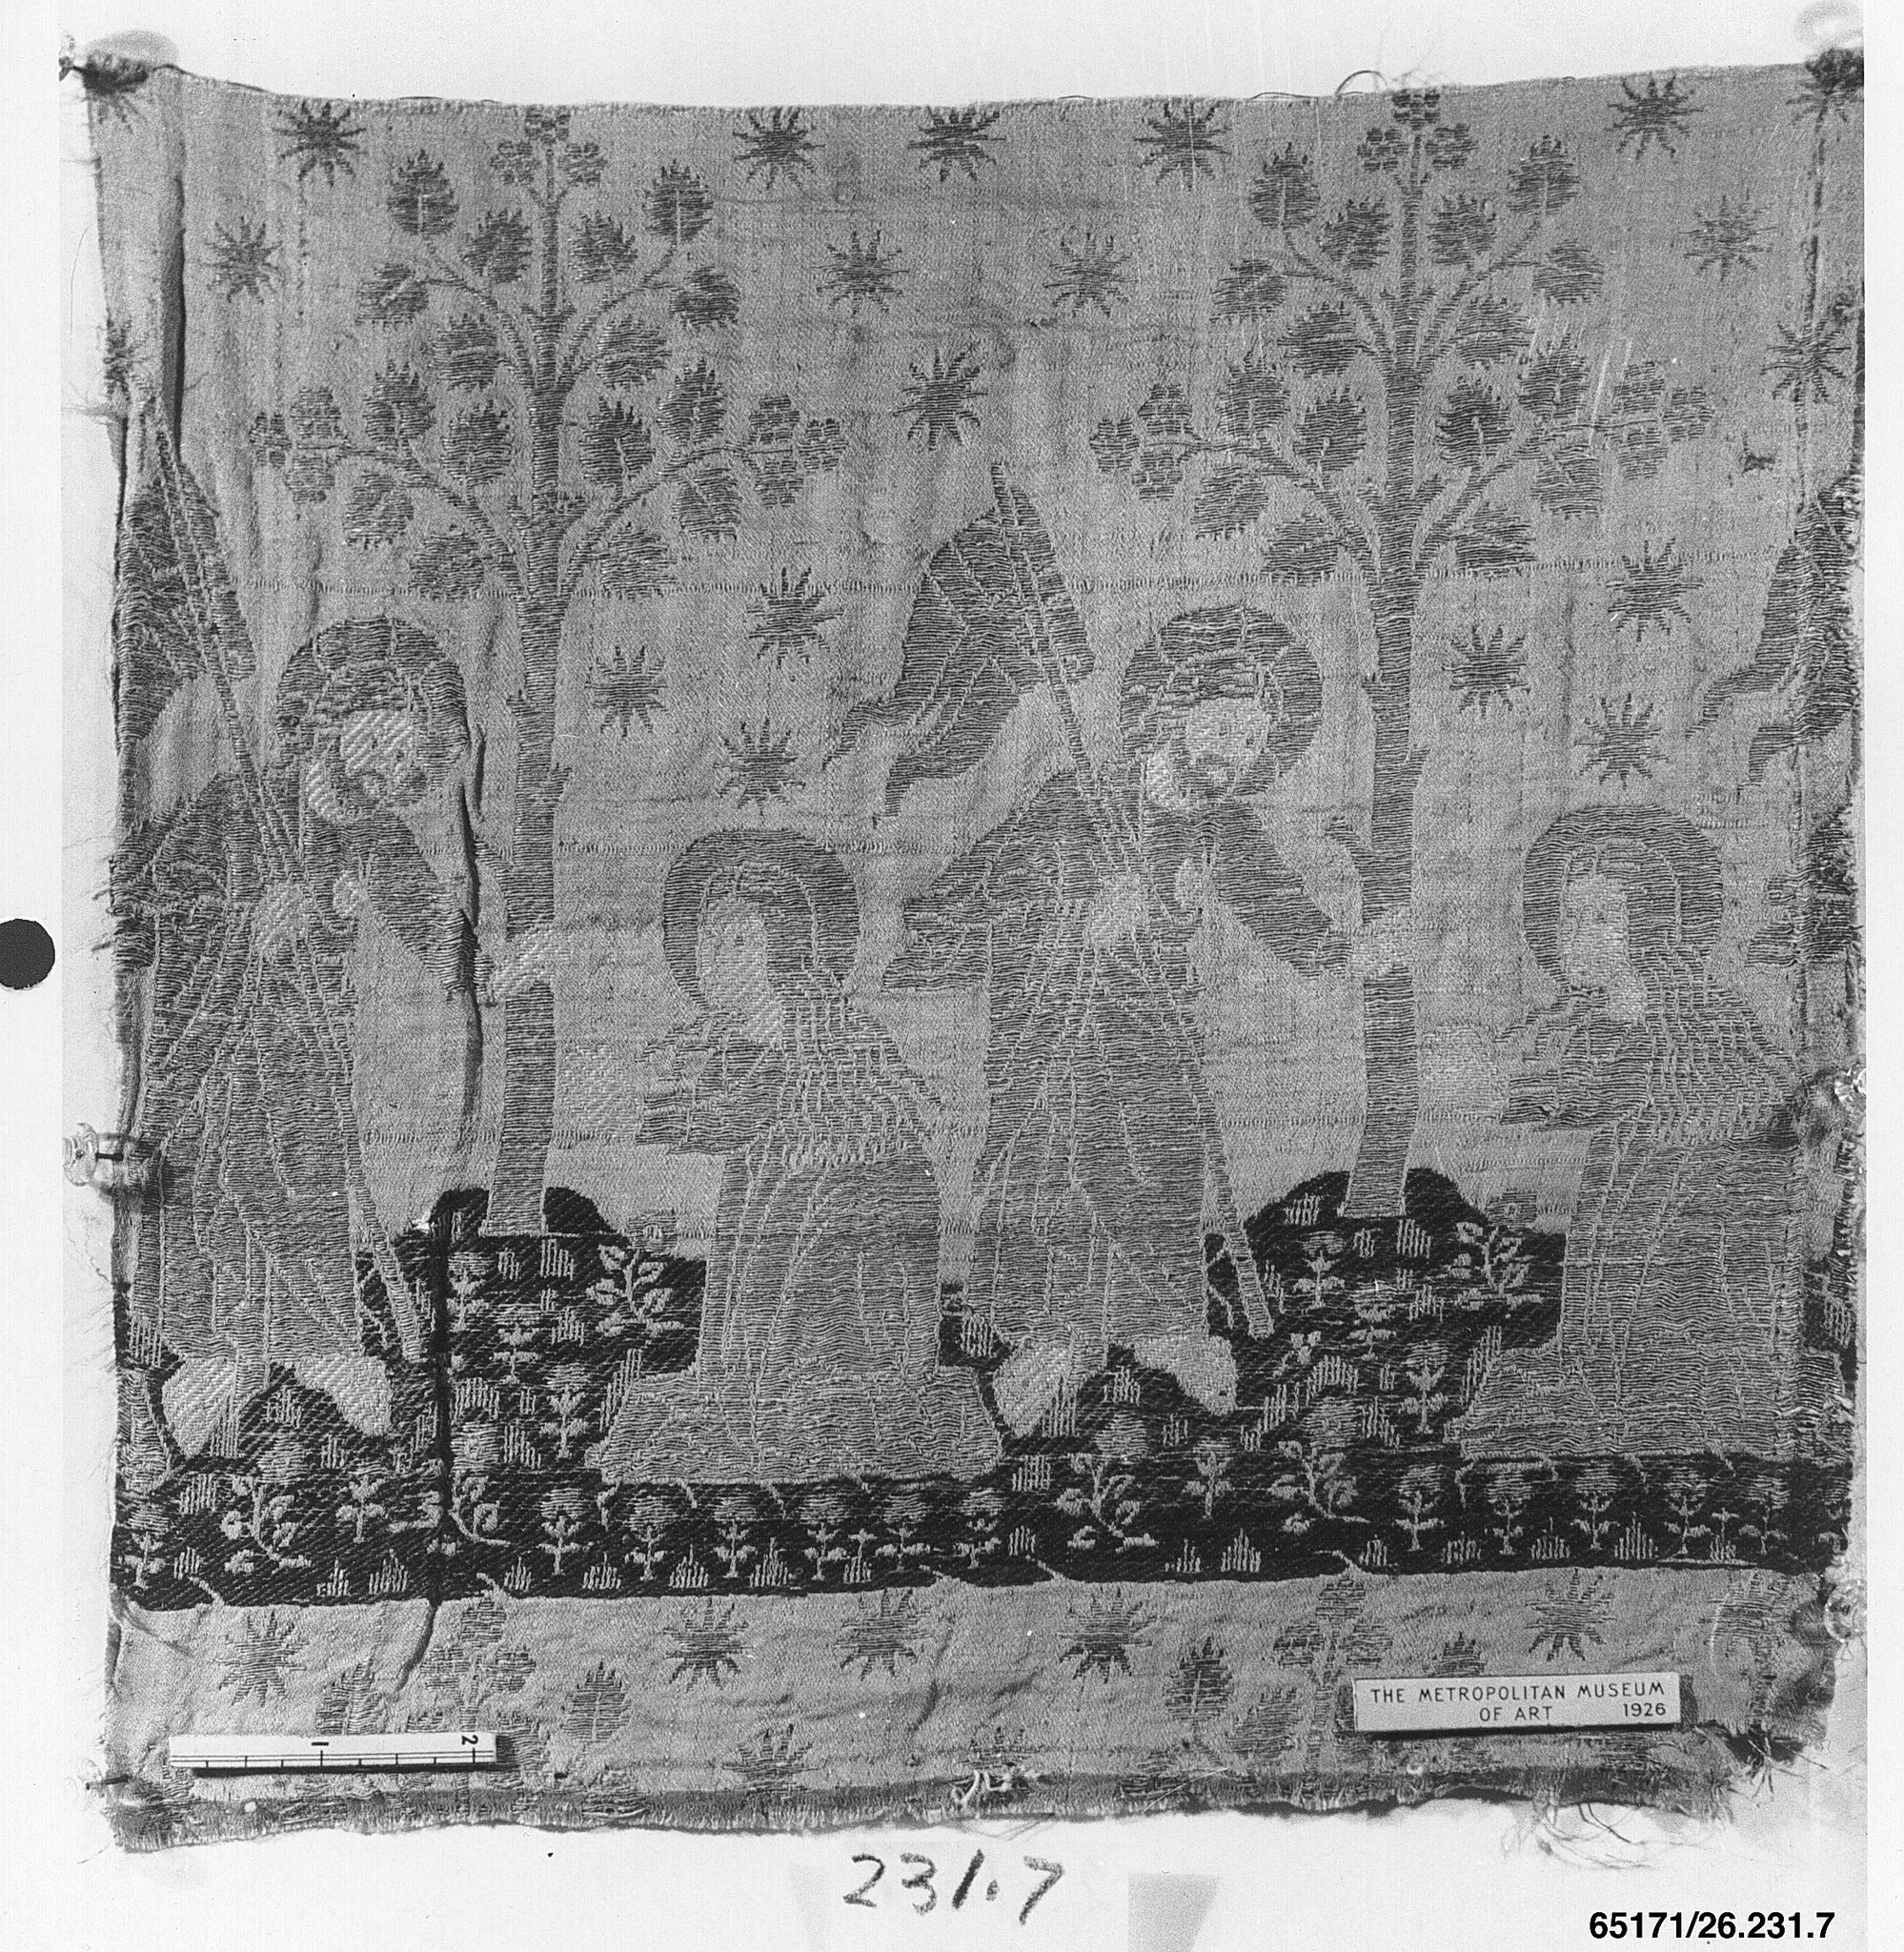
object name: border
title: Noli Me Tangere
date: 1401-1433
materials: metal thread, silk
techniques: weave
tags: trees,christ,mary magdalene,flags